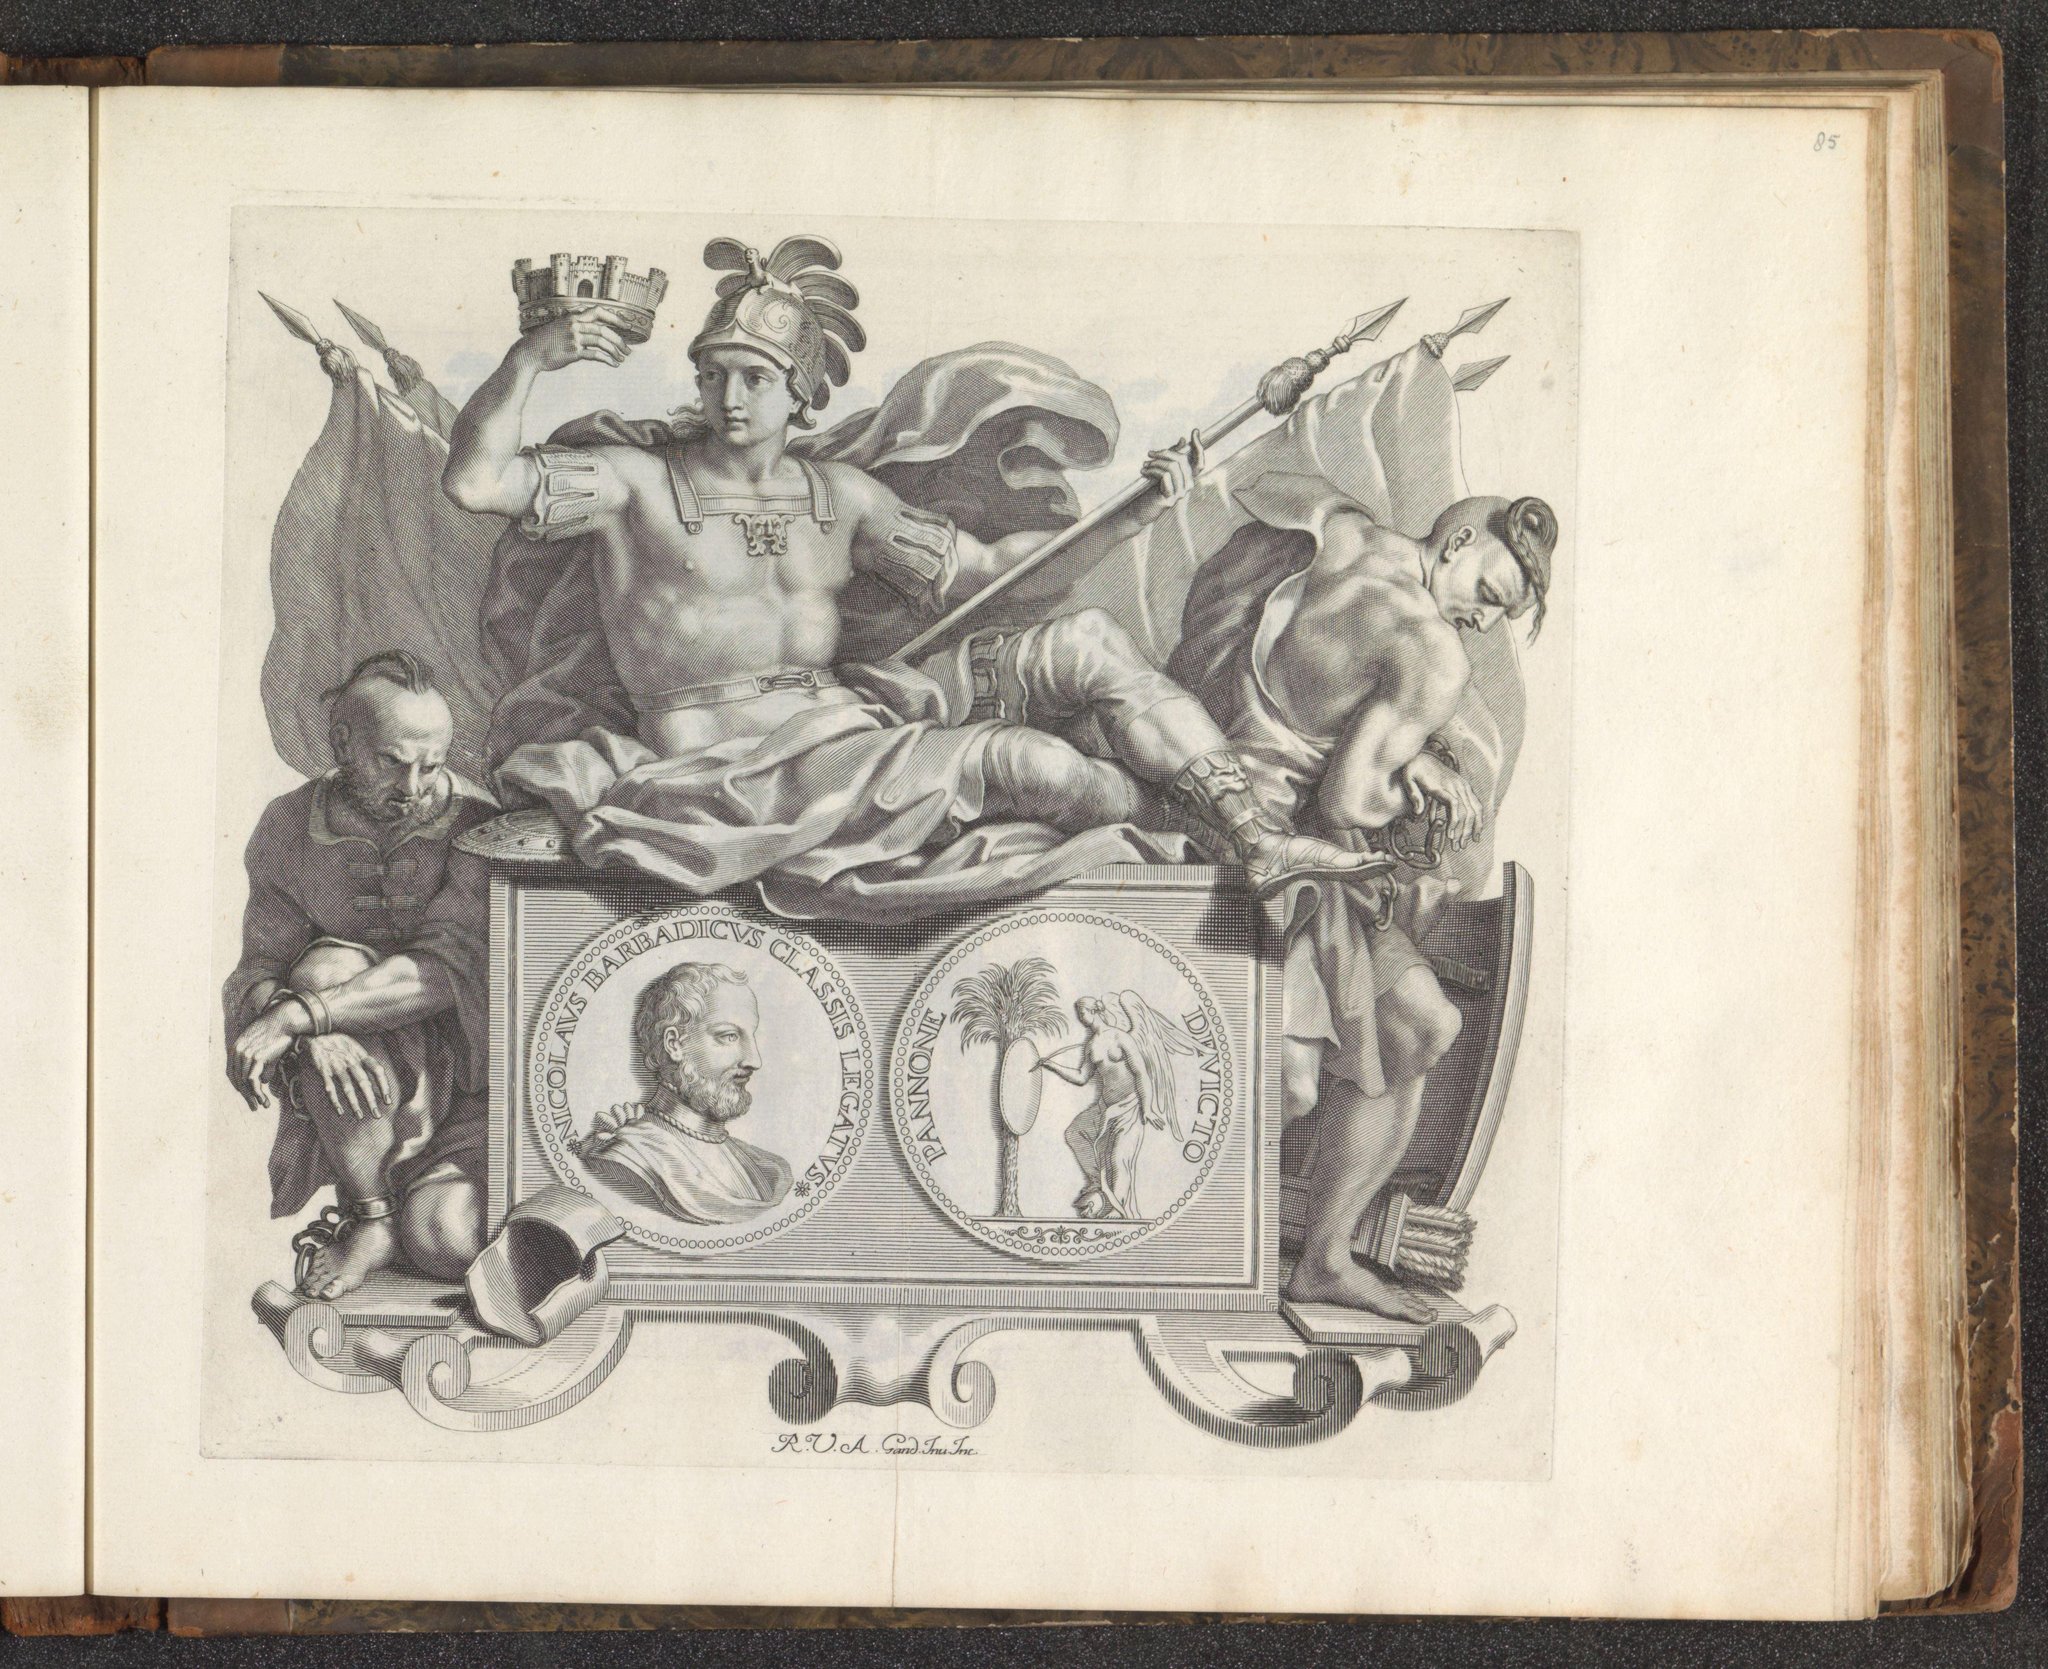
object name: print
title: Portret van Nicolo Barbarigo en de personificatie van Militaire Overwinning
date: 1673-1743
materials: paper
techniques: engraving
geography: rome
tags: victoria as roman personification, medal (considered as a piece of sculpture, regardless of its specific function), banner, standard (as symbol of the state, etc.), trees: palm-tree, prisoner of war (after the battle)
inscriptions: collector's mark: Lugt 2228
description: Voetstuk in de vorm van een cartouche. Daarop een medaillon met op de voorkant het portret van Nicolo Barbarigo. Op de achterkant schrijft Victoria op een schild hangend aan een palmboom. Op het voetstuk zit de Militaire Overwinning, een geharnaste vrouw met een speer en een muurkroon. Achter haar enkele buitgemaakte vaandels. Links en rechts twee krijgsgevangenen. De prent maakt deel uit van een album.